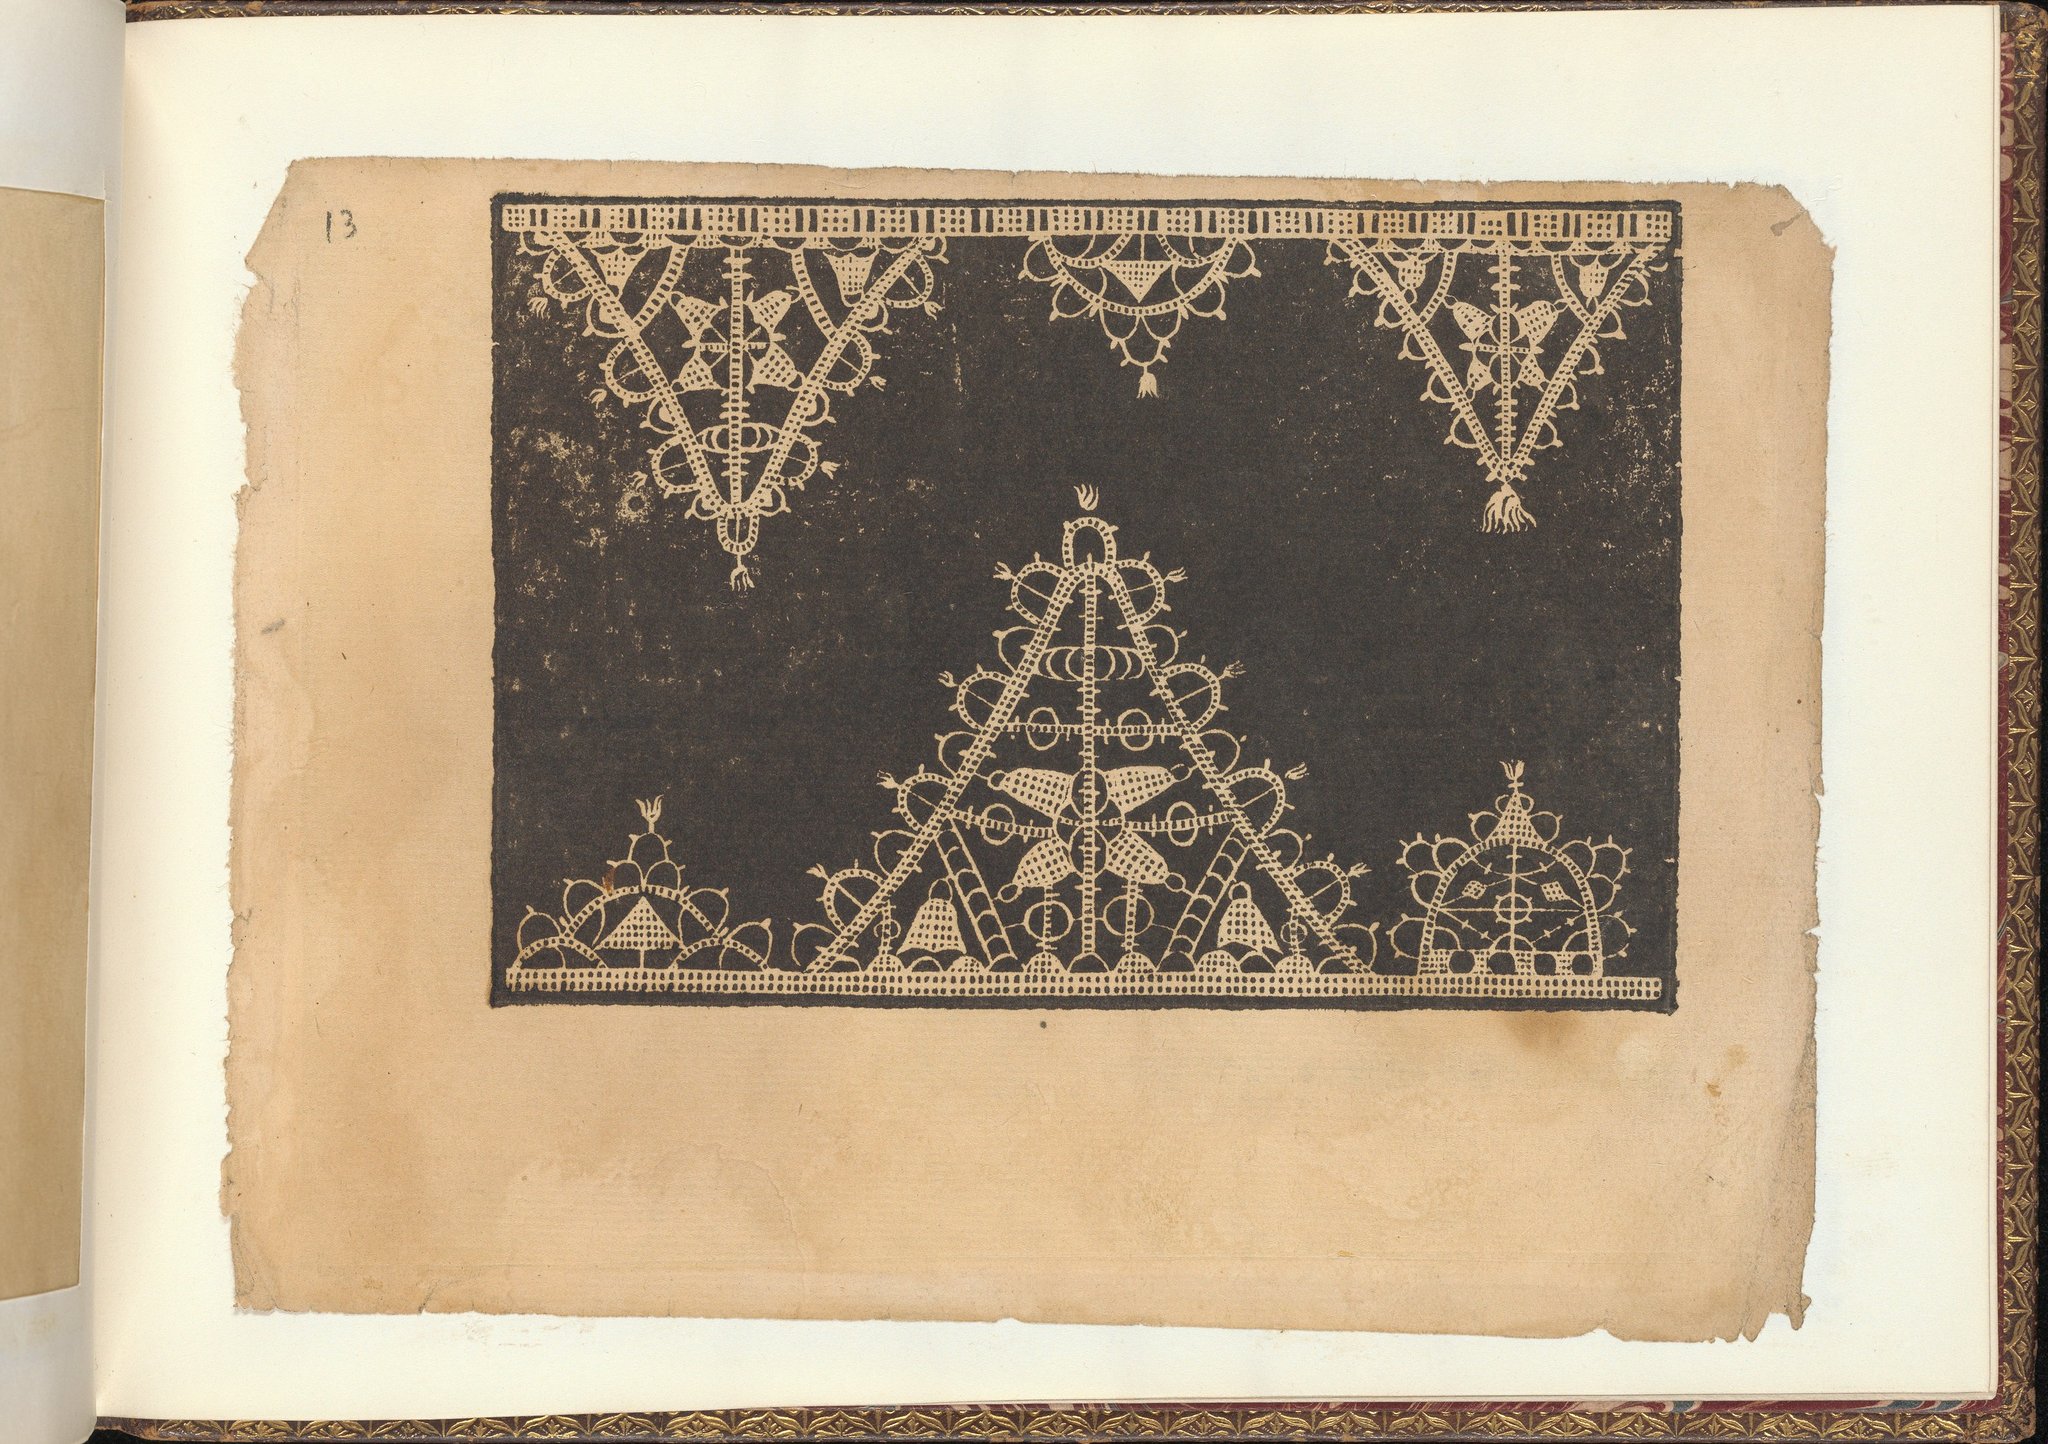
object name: book print ornament architecture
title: Prima parte de' fiori, page 14 (recto)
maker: giovanni battista ciotti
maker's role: author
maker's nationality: italian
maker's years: 1555-1659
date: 1591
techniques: woodcut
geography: italy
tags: ornament